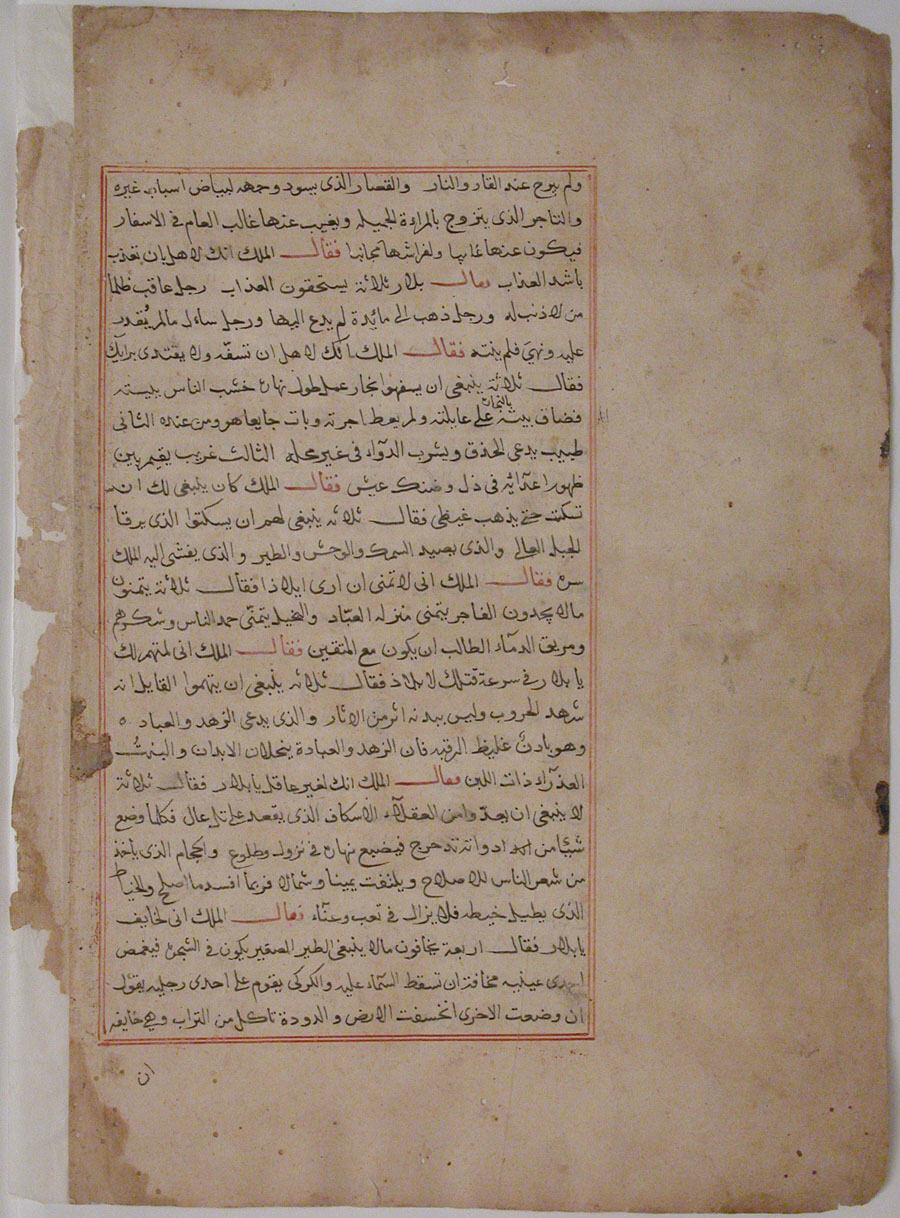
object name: folio from an illustrated manuscript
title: Page of Calligraphy from a Kalila wa Dimna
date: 1526-1550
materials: ink, paper, watercolor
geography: india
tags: arabic,calligraphy